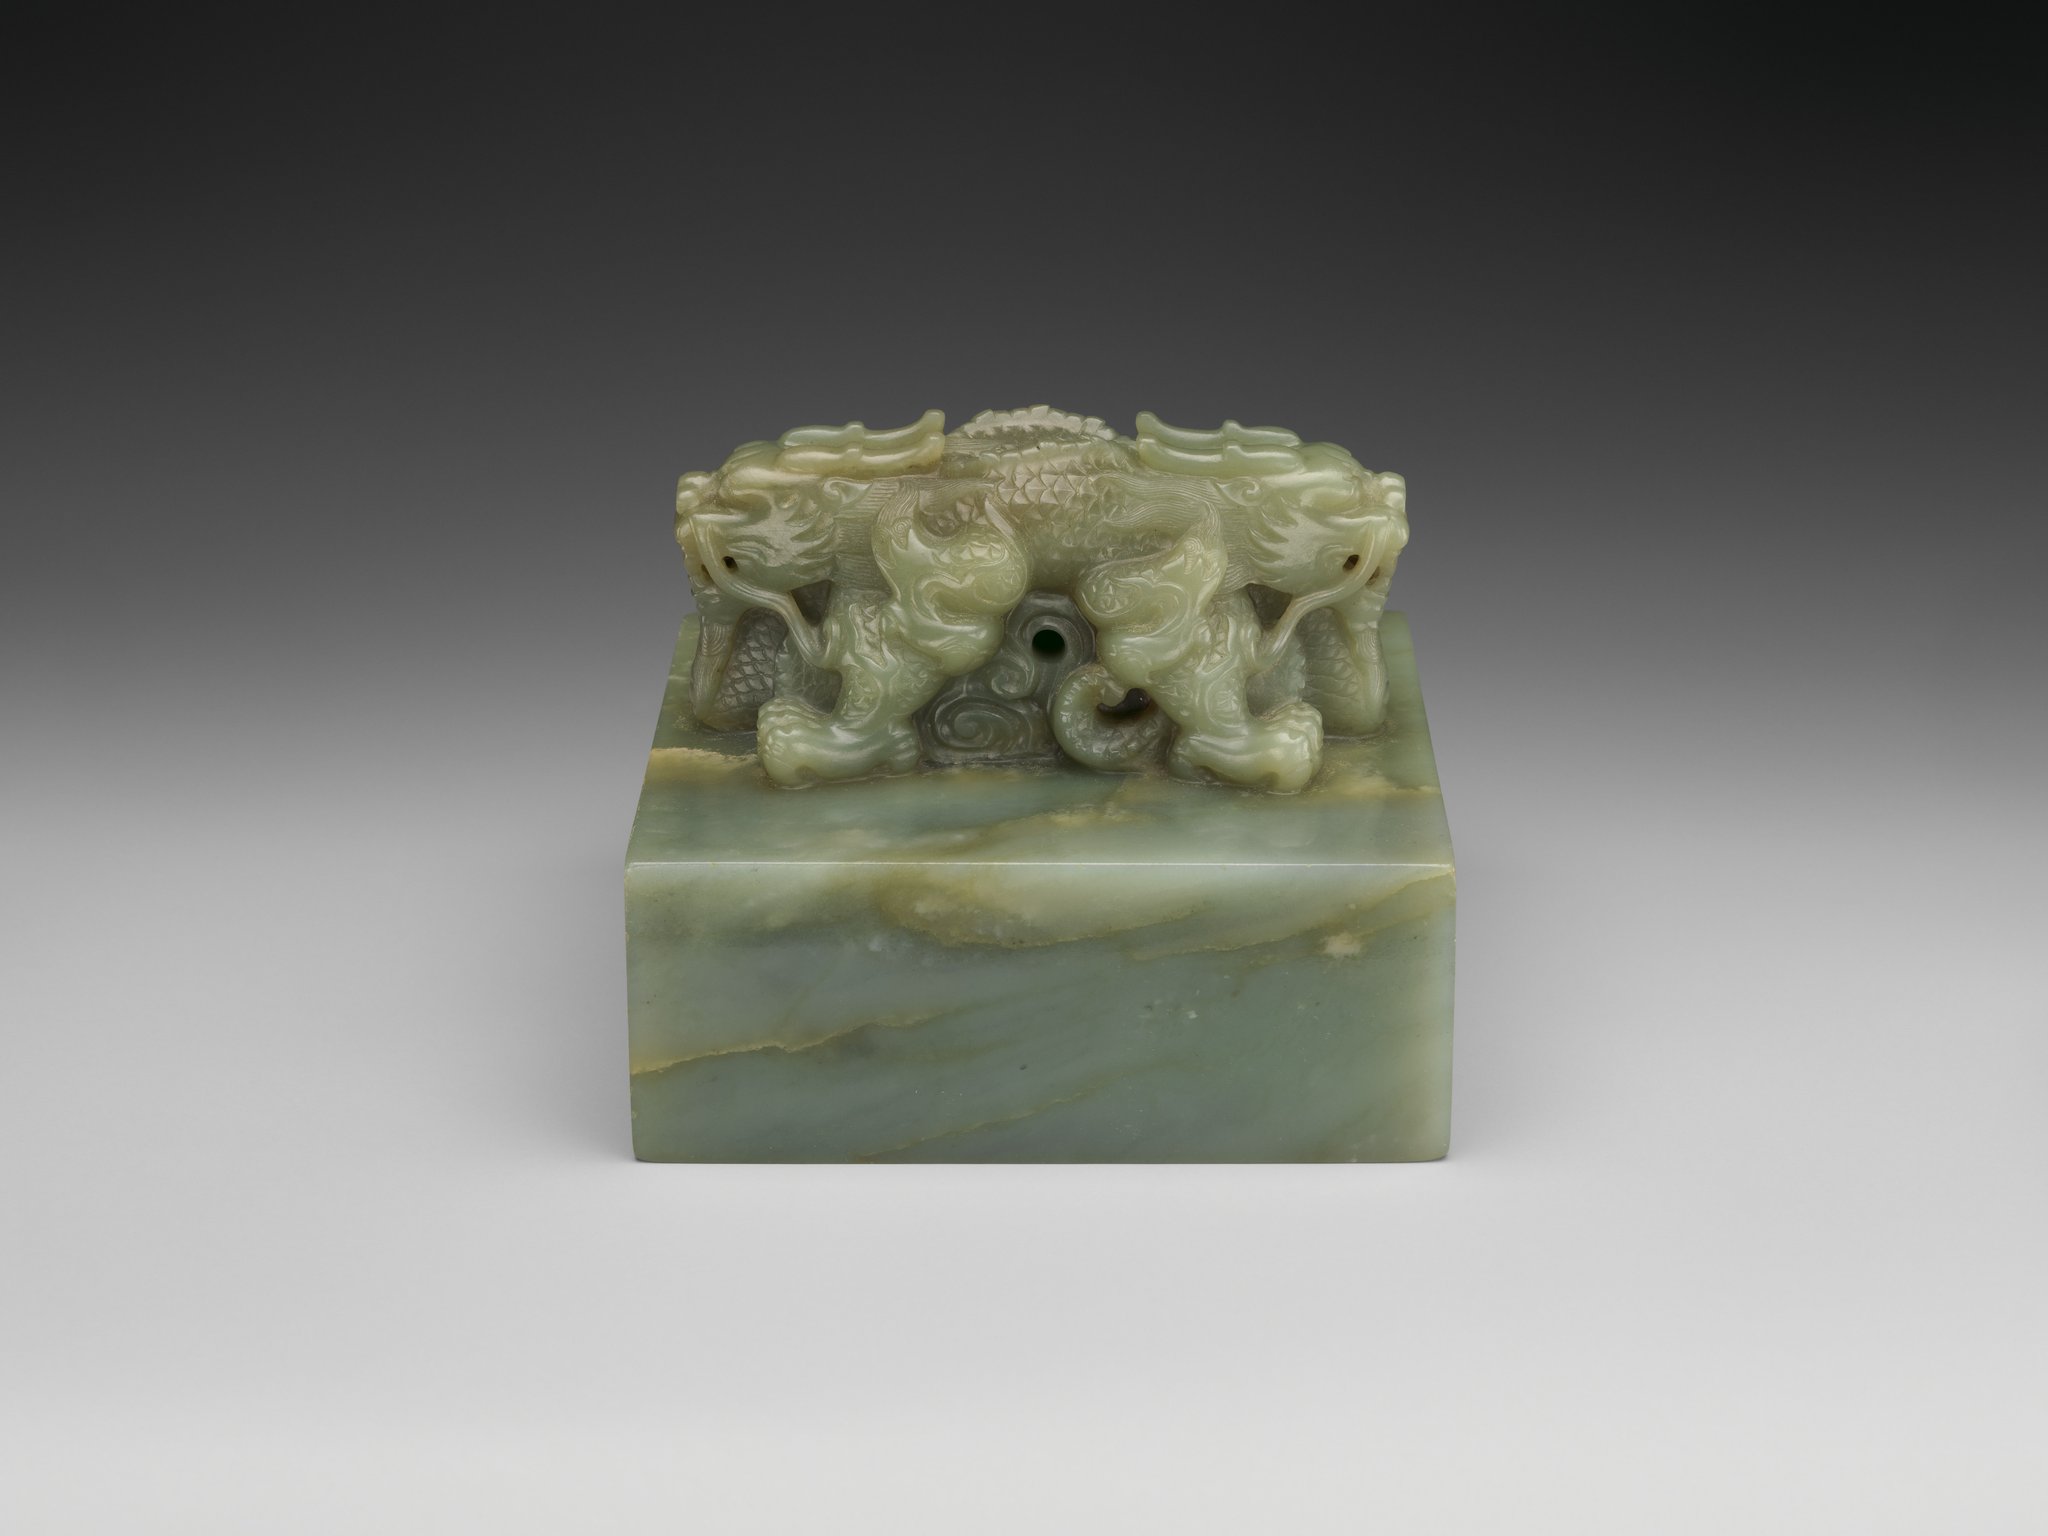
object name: seal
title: Seal with two dragons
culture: chinese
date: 1701-1800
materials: jade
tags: dragons